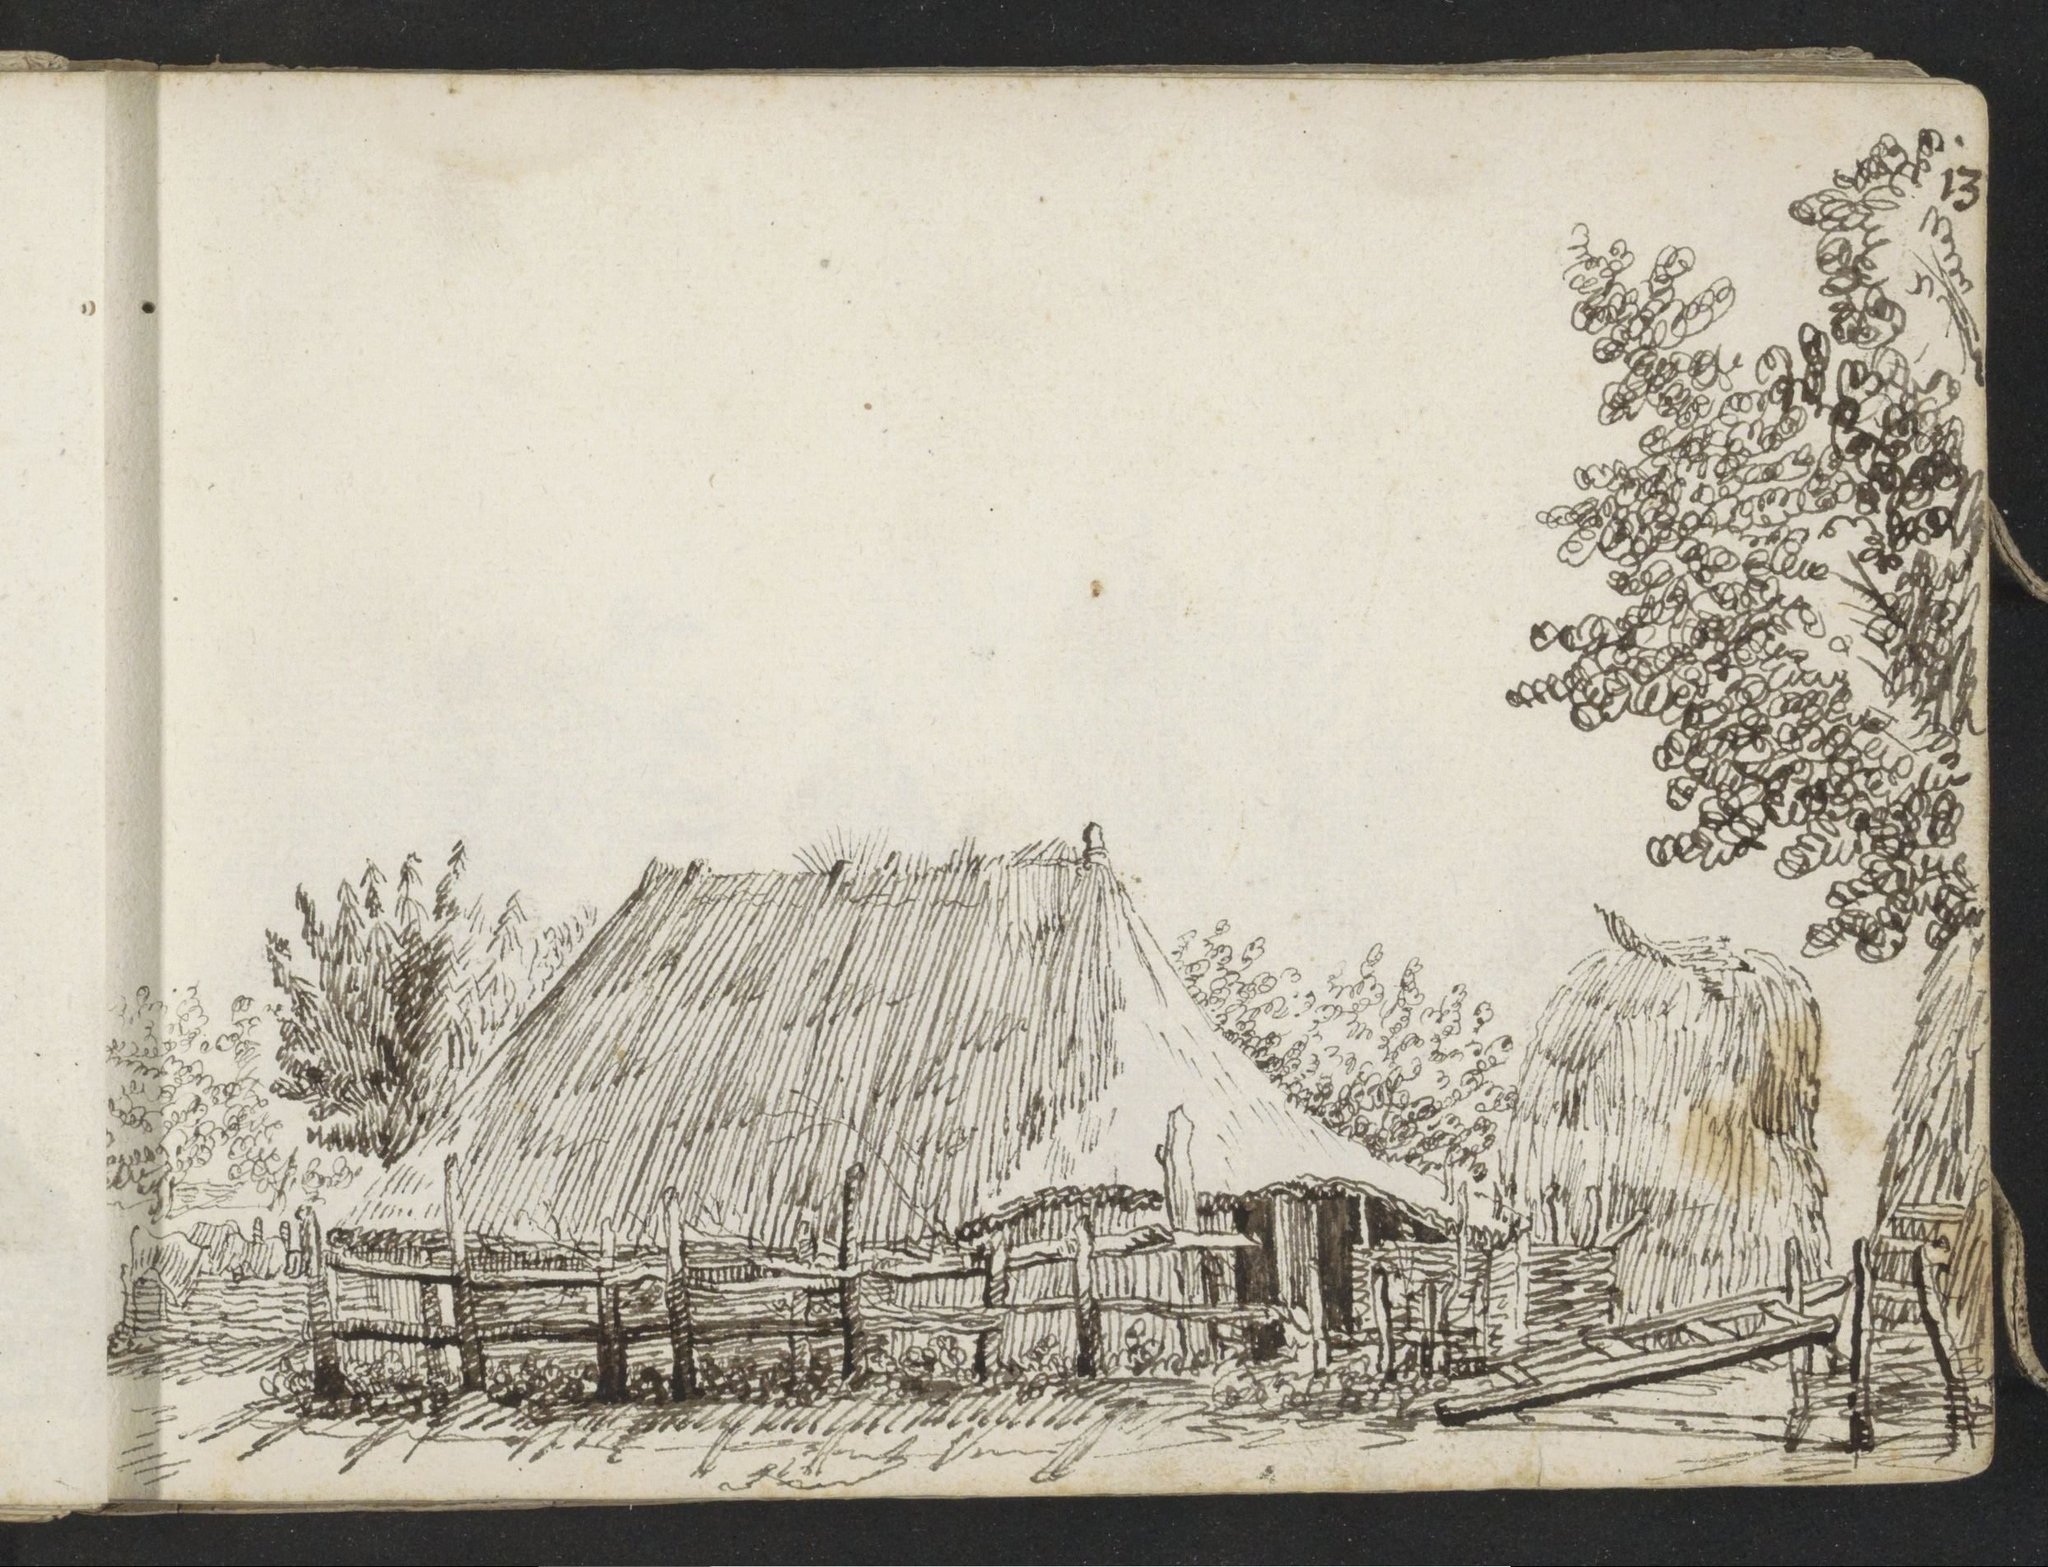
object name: sketchbook leaf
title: Boerenschuur en hooiberg buiten Zwolle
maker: gerard ter borch (ii)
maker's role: draughtsman, painter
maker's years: 1617-1681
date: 1631-1633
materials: ink, paper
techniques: pen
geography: zwolle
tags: fence, wall, paling, hay-stack, farm (building)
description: Blad 13 recto uit een schetsboek met 55 bladen.